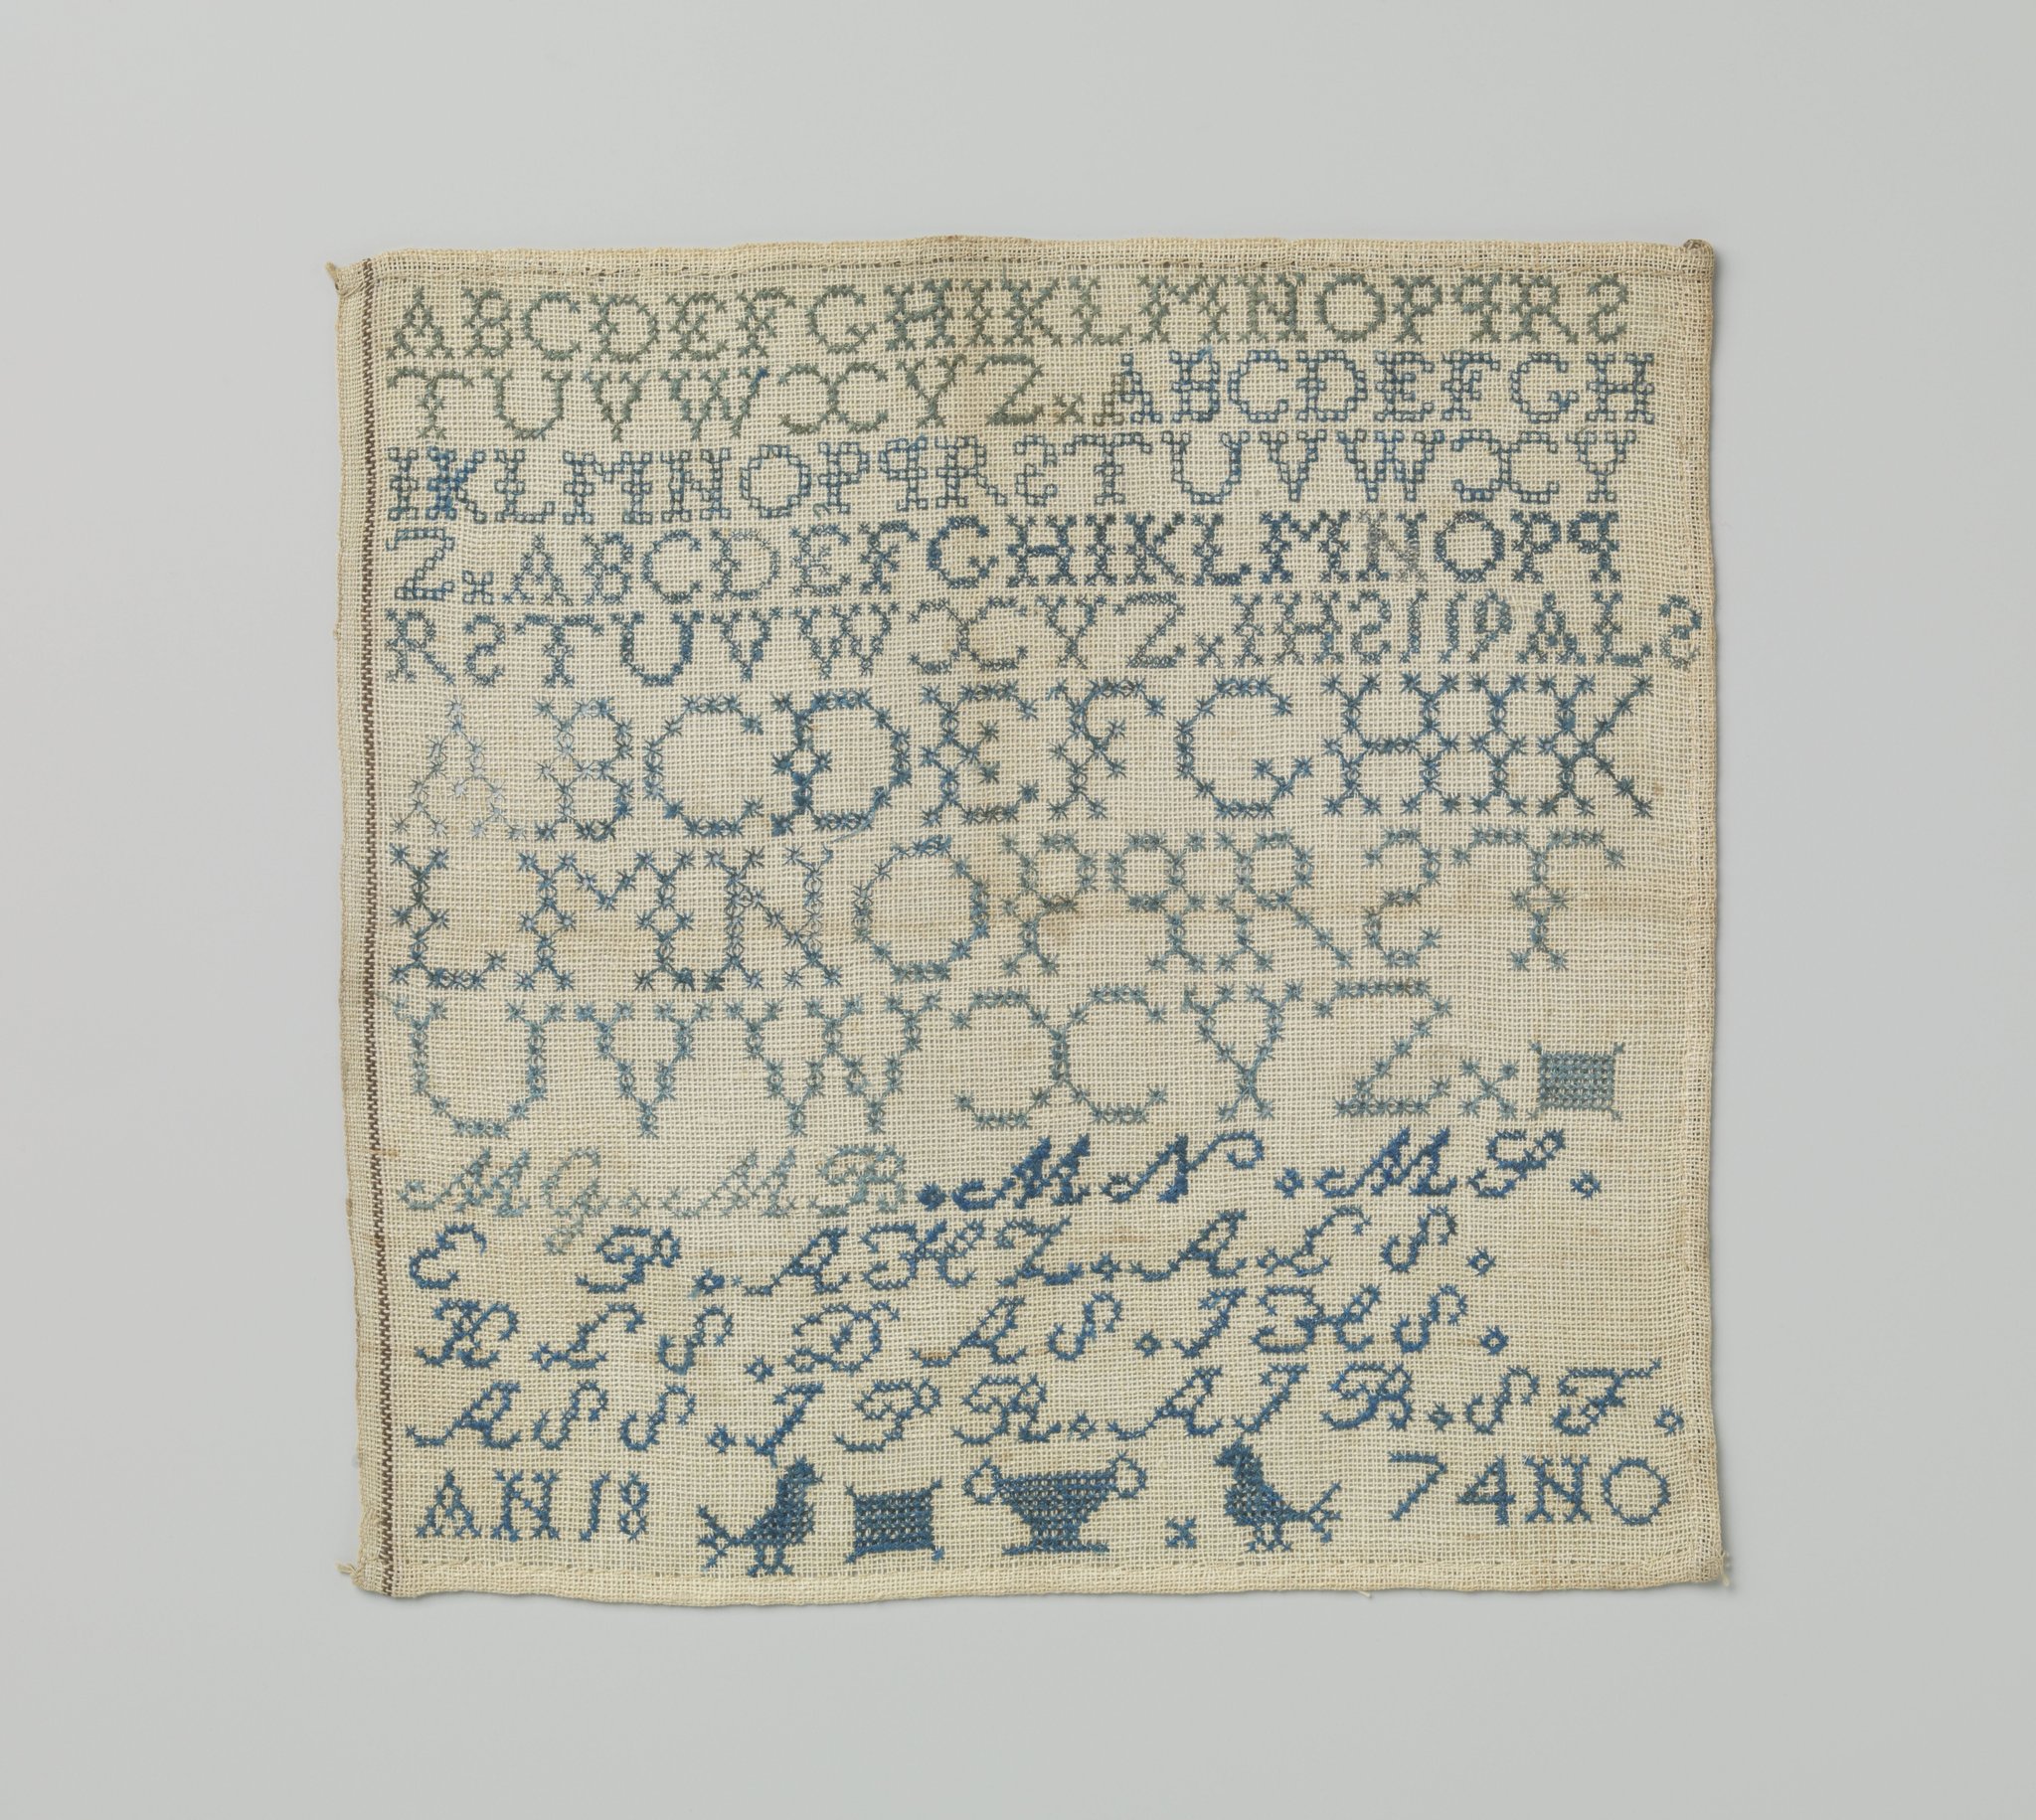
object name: merkdoek, merklap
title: Merklap van zijde op katoen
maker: johanna hendrika scholtz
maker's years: 1861-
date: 1874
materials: cotton, silk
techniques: embroidered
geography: dutch reformed diaconie orphanage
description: Merklap van zijde op katoen. Het borduurwerk bestaat uit de initialen MG, MB, MN, MS, het alfabet, twee vogels, een vaas en een rechthoek. De lap is gedateerd: 1874.